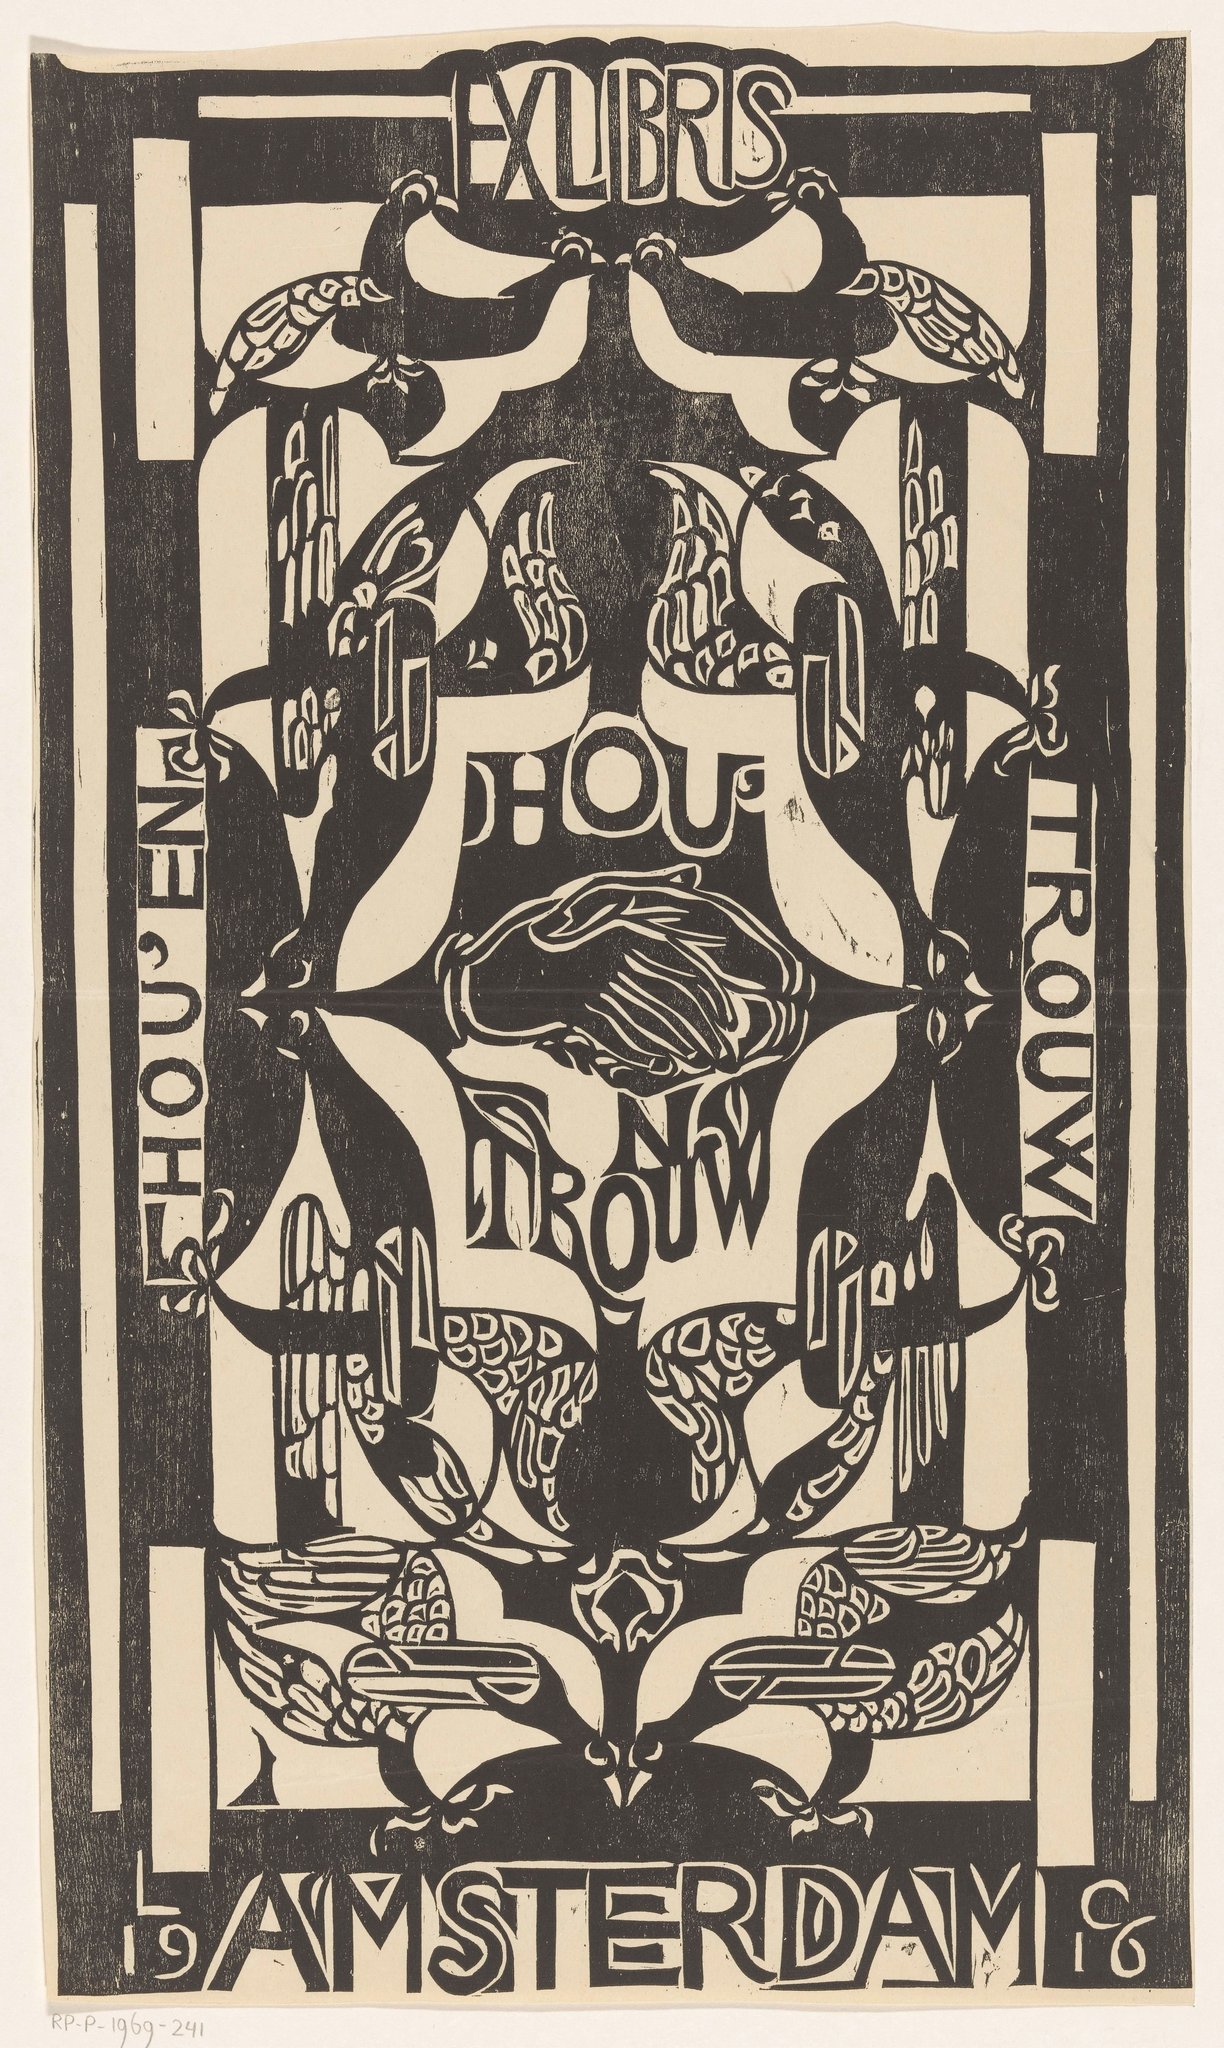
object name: print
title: Ex libris van de vereniging Hou'en Trouw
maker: carel adolph lion cachet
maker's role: draughtsman, print maker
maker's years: 1864-1945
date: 1916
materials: paper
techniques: woodcut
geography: amsterdam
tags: shaking hands, 'dextrarum junctio', birds, amsterdam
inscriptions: collector's mark: Lugt 2228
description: In het midden twee handen die elkaar schudden. Links verticaal 'Hou' en', rechts verticaal 'trouw'. Boven en onder gestileerde vogels.